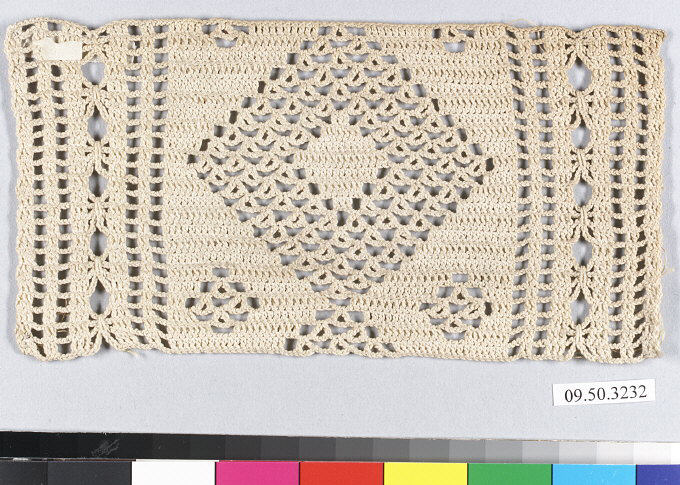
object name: sample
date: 1801-1900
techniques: crochet